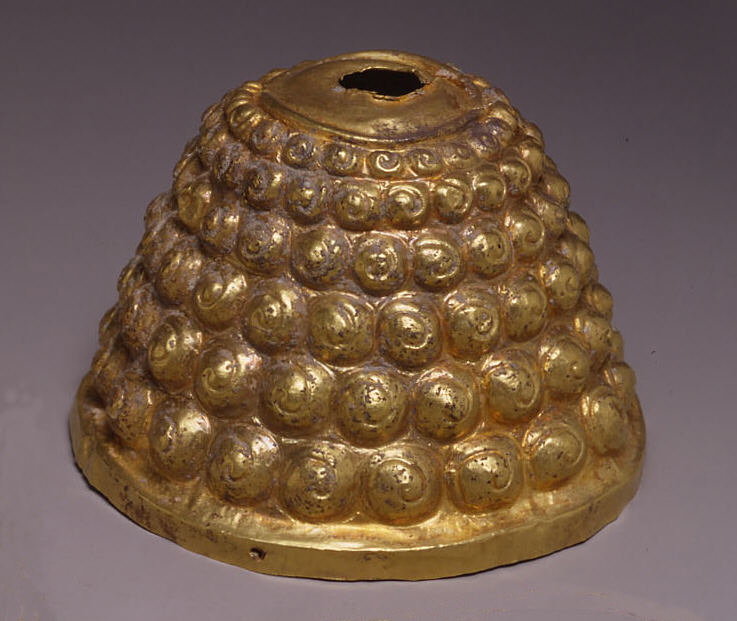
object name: cover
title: Ushnisha Cover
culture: indonesian, javanese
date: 701-933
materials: gold